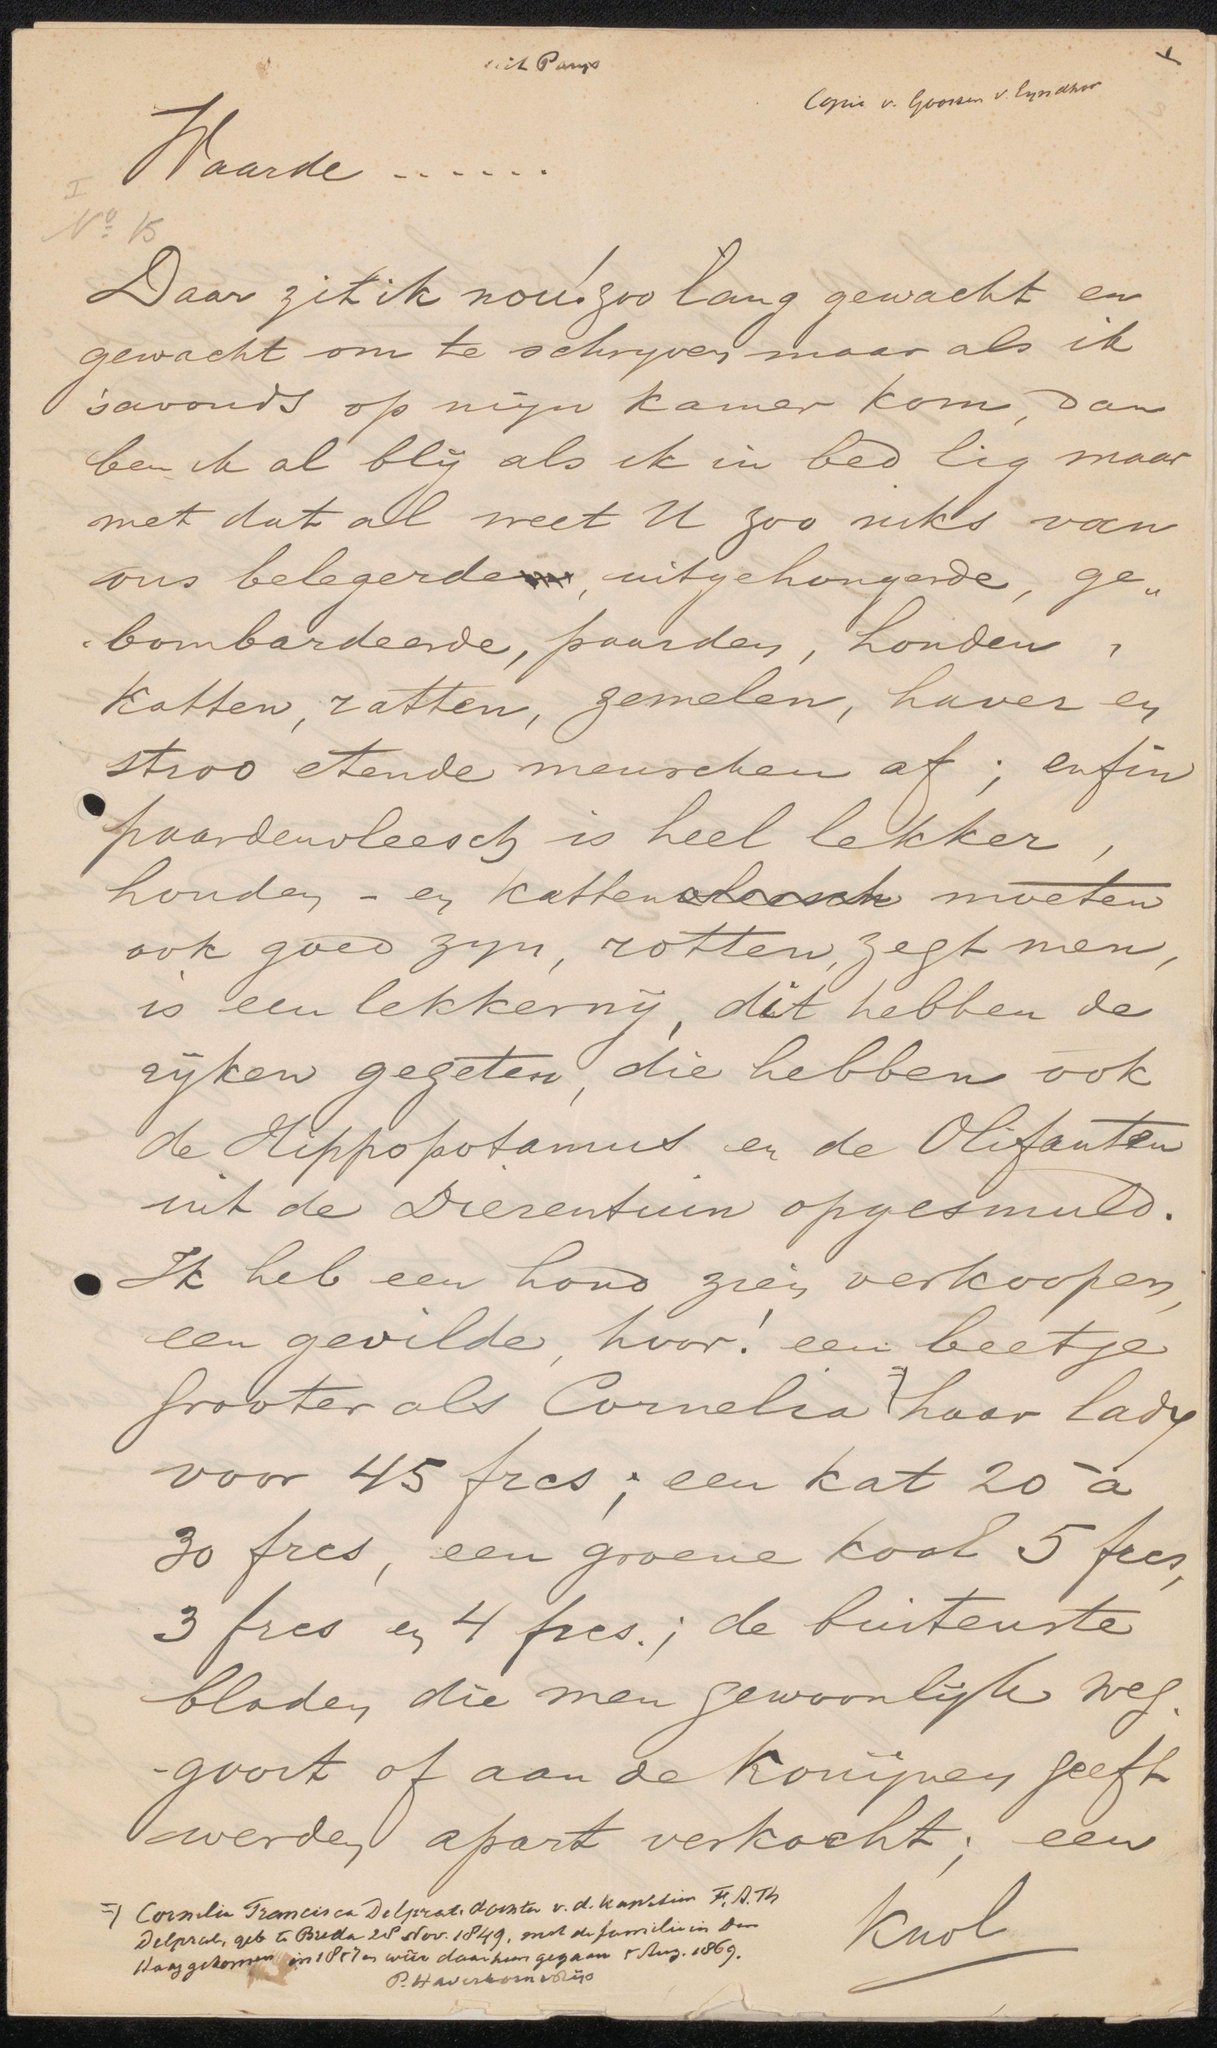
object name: letter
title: Transcriptie van een brief aan E. Goossens van Eijndhoven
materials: ink, paper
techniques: pen, writing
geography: paris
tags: the hague, painter, print maker, draughtsman, jacob maris, paris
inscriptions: collector's mark: Lugt 2233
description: Transcriptie bevat een aantekening van Pieter Haverkorn van Rijsewijk.